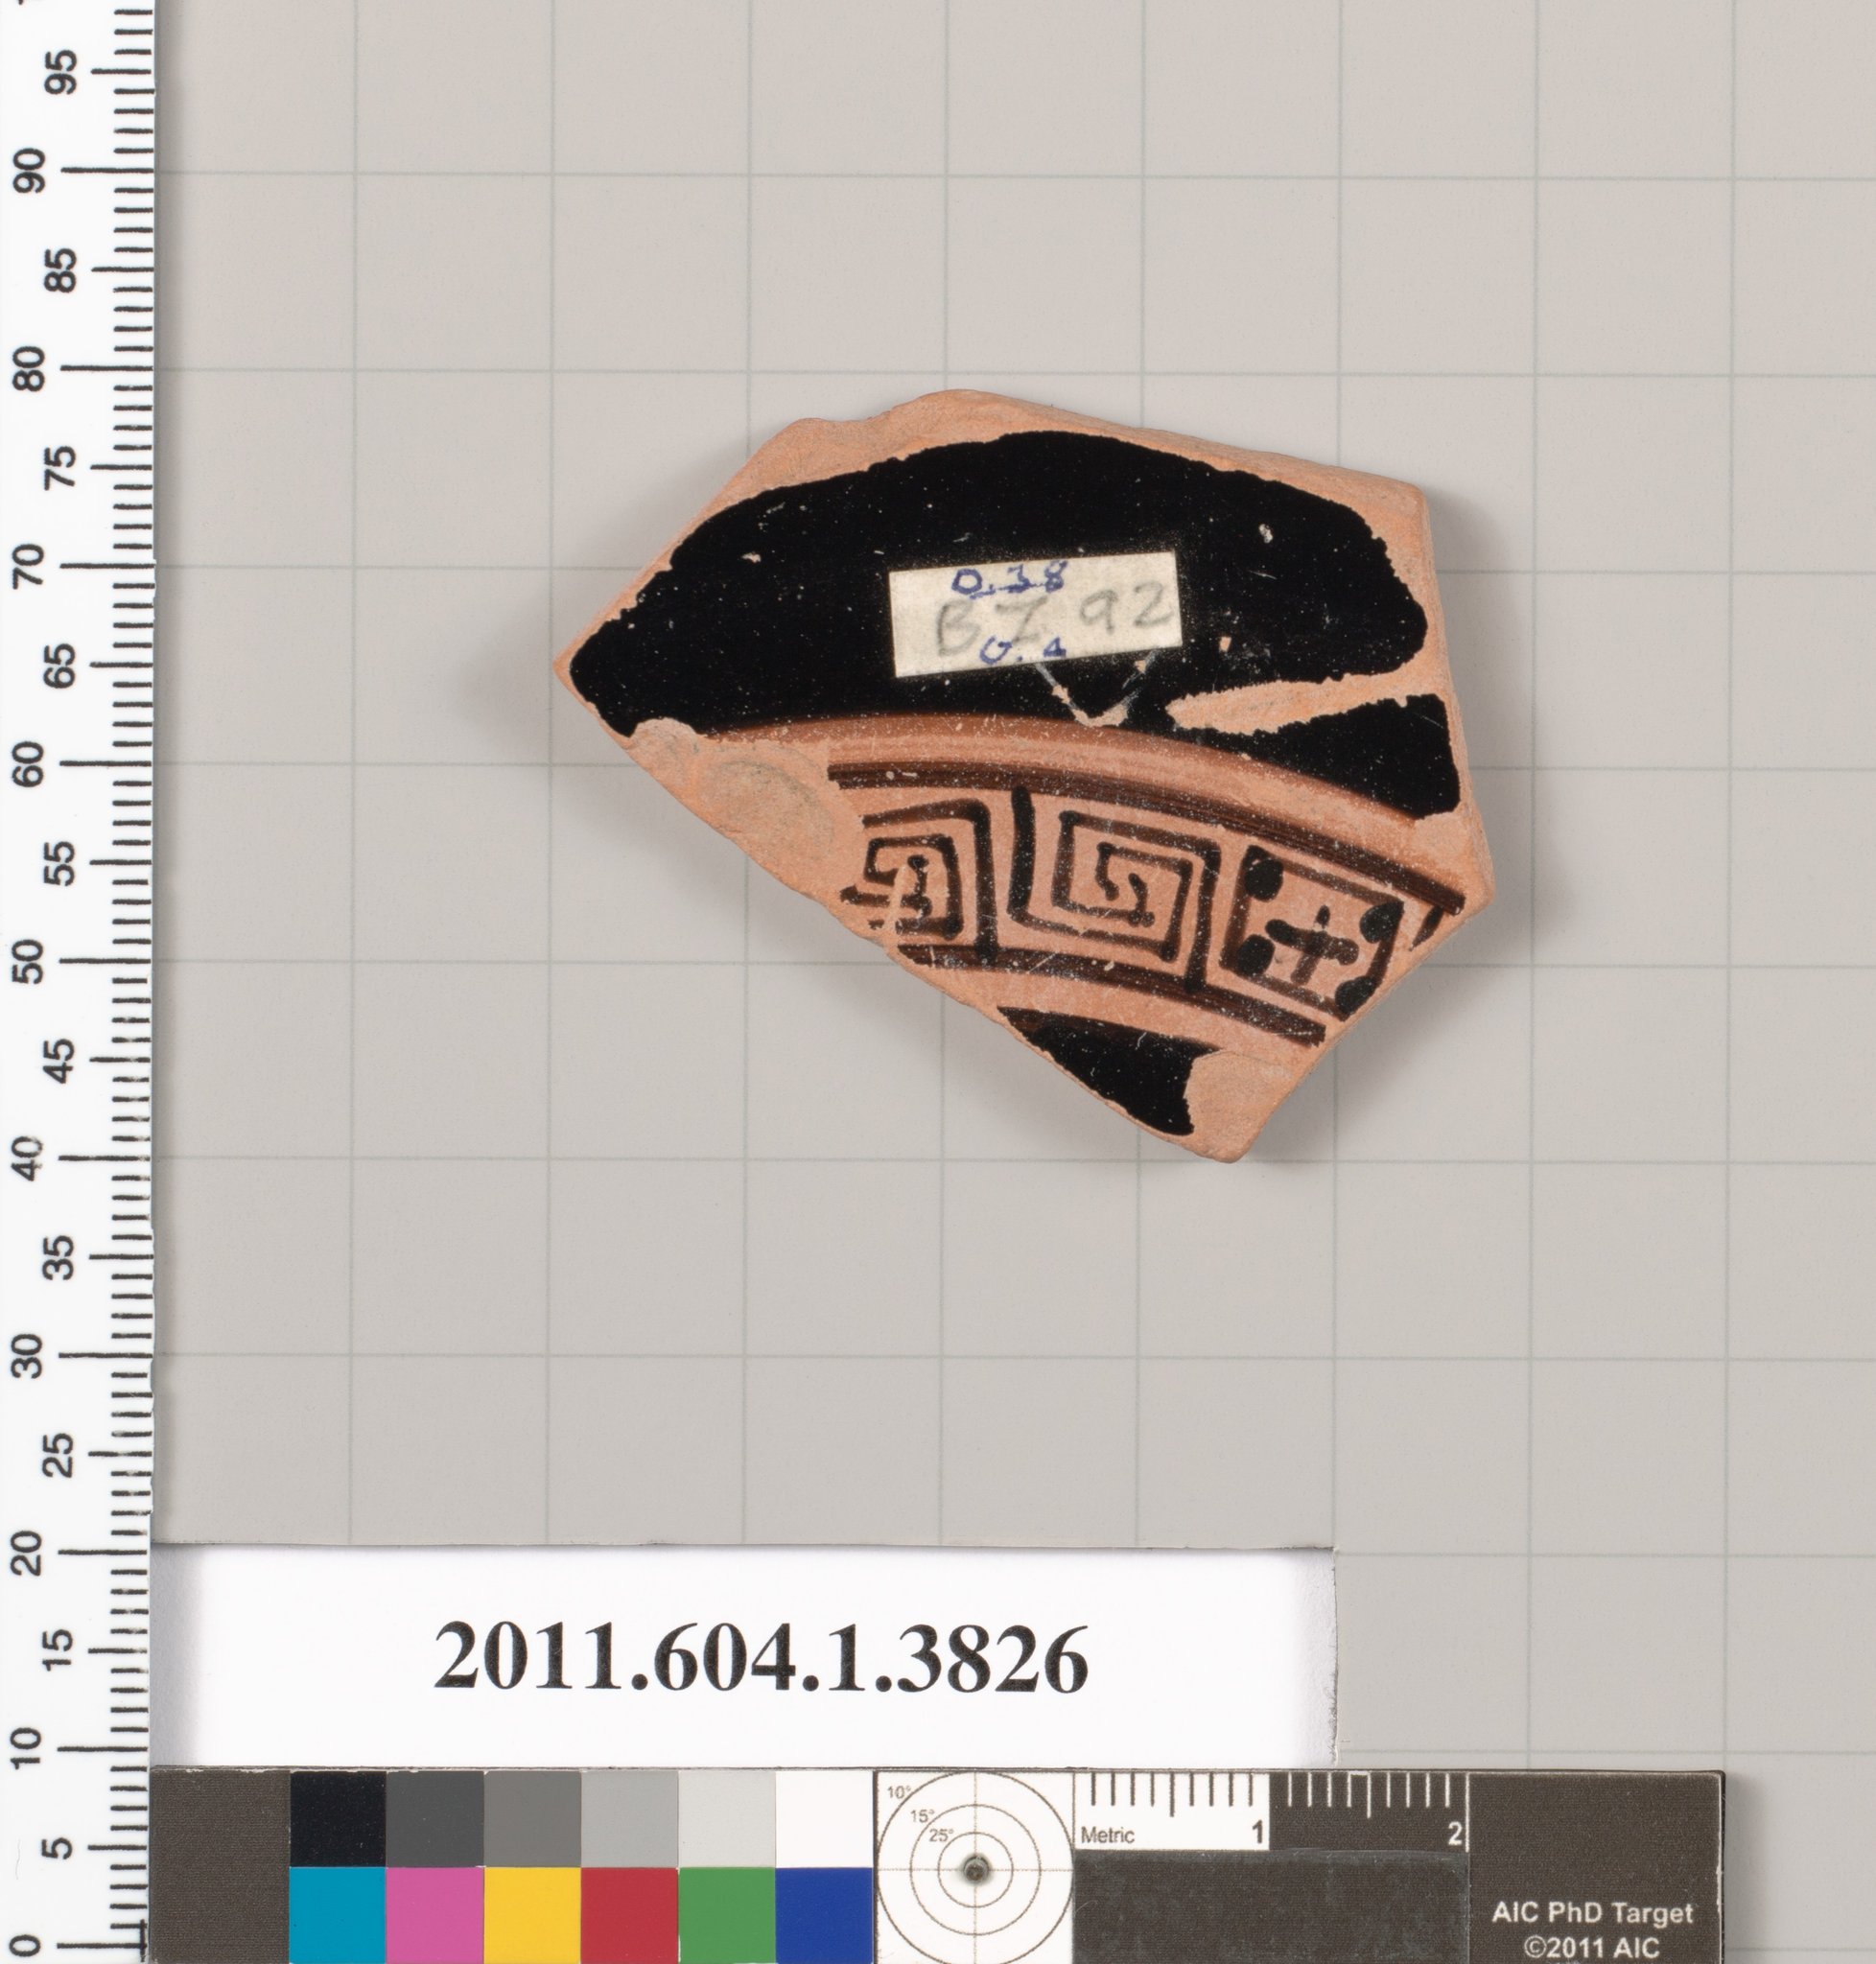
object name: kylix fragment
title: Terracotta fragment of a kylix (drinking cup)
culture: greek, attic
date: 475-451 BCE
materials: terracotta